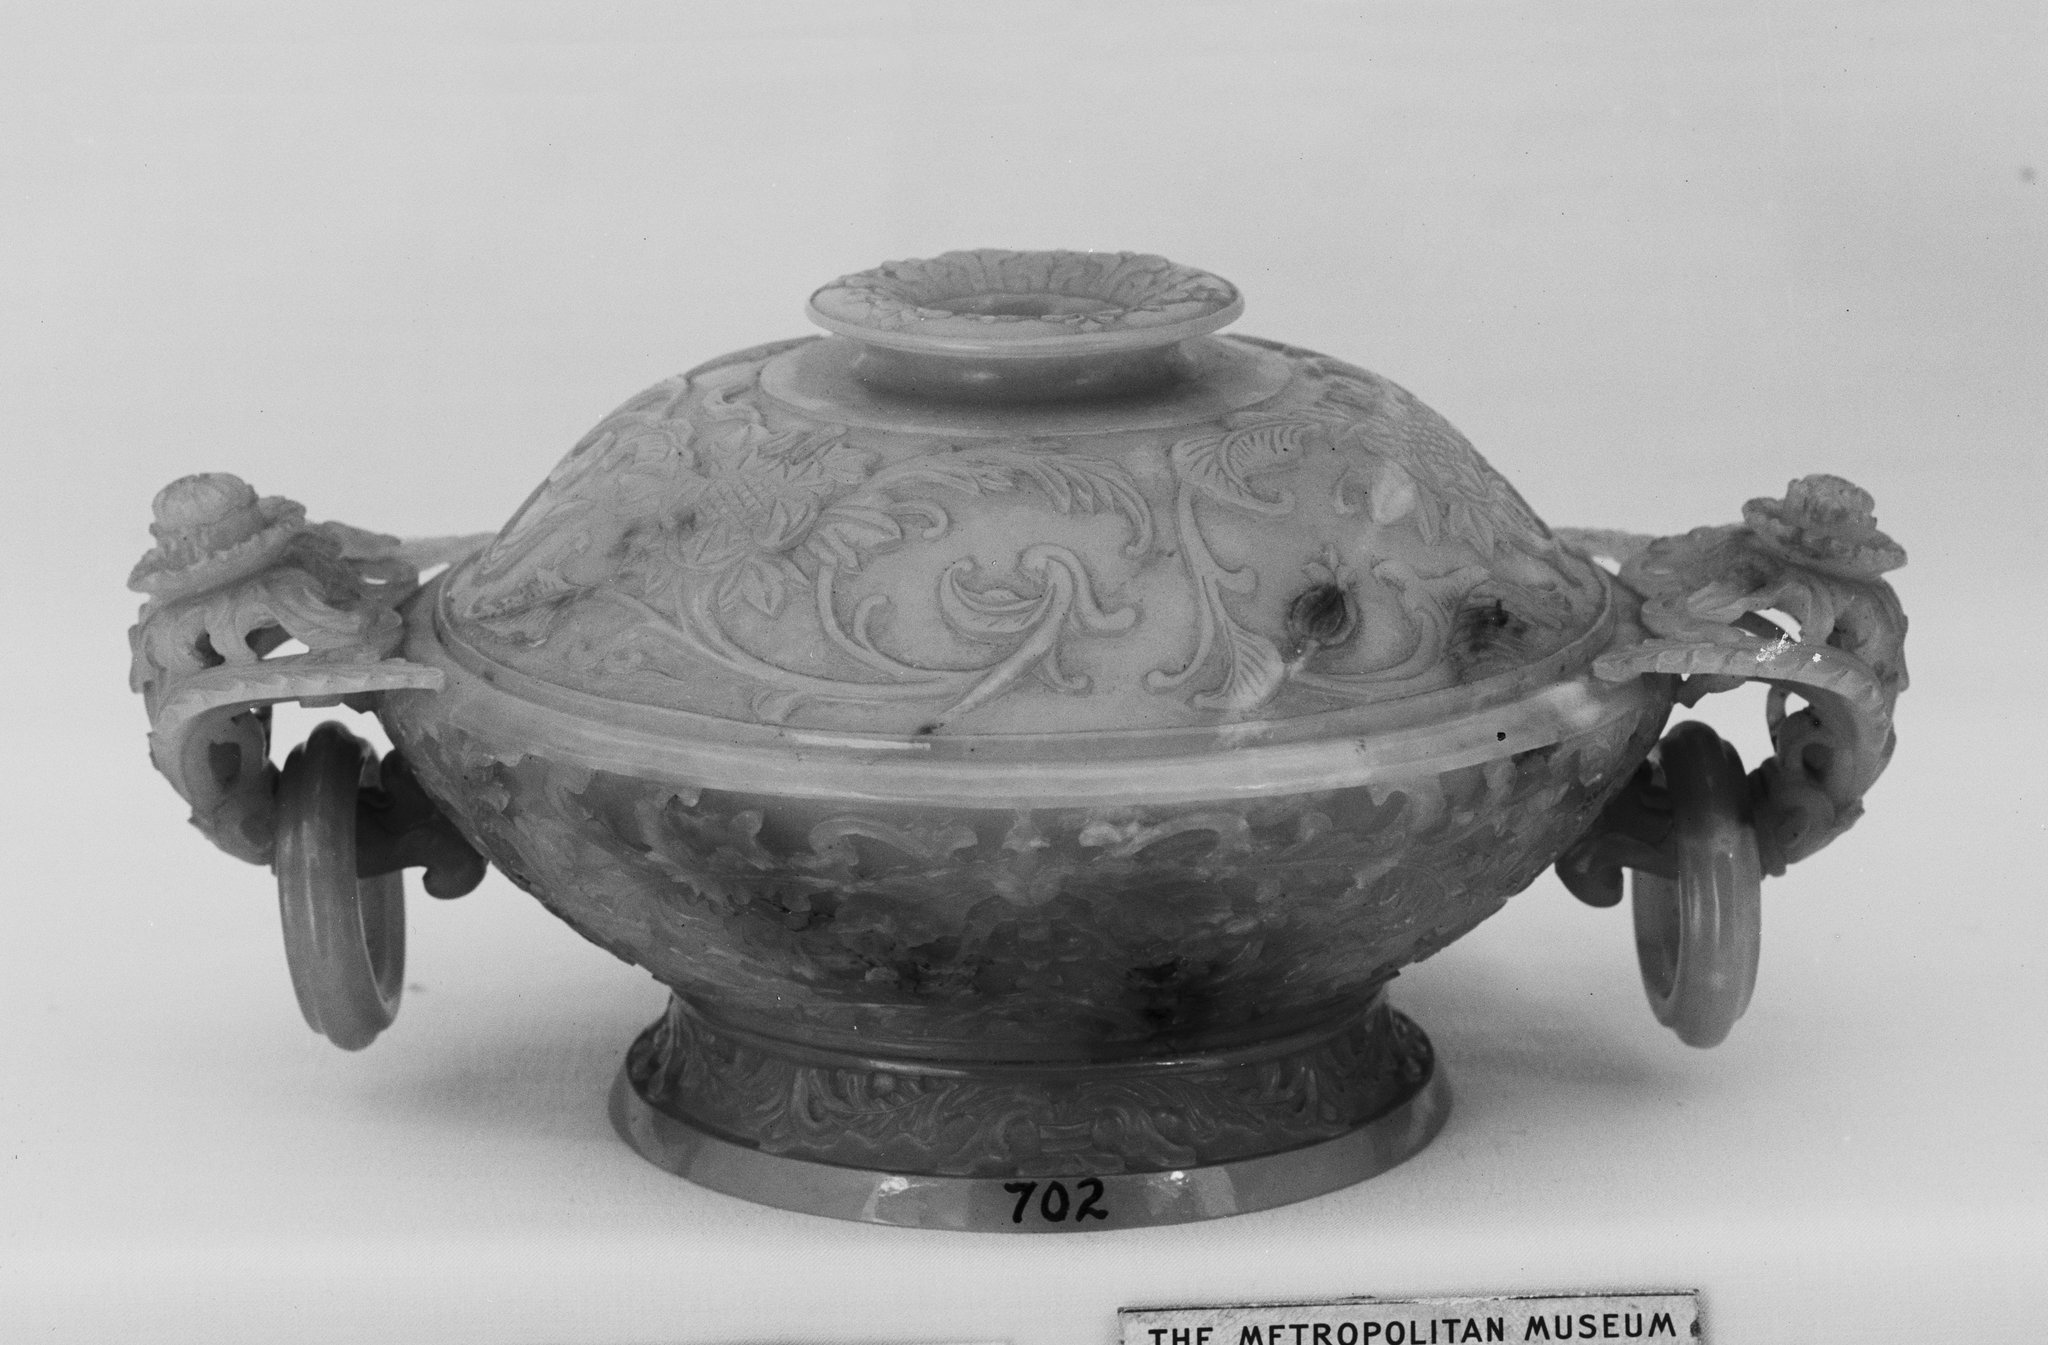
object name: incense burner with cover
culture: chinese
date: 1796-1820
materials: jade